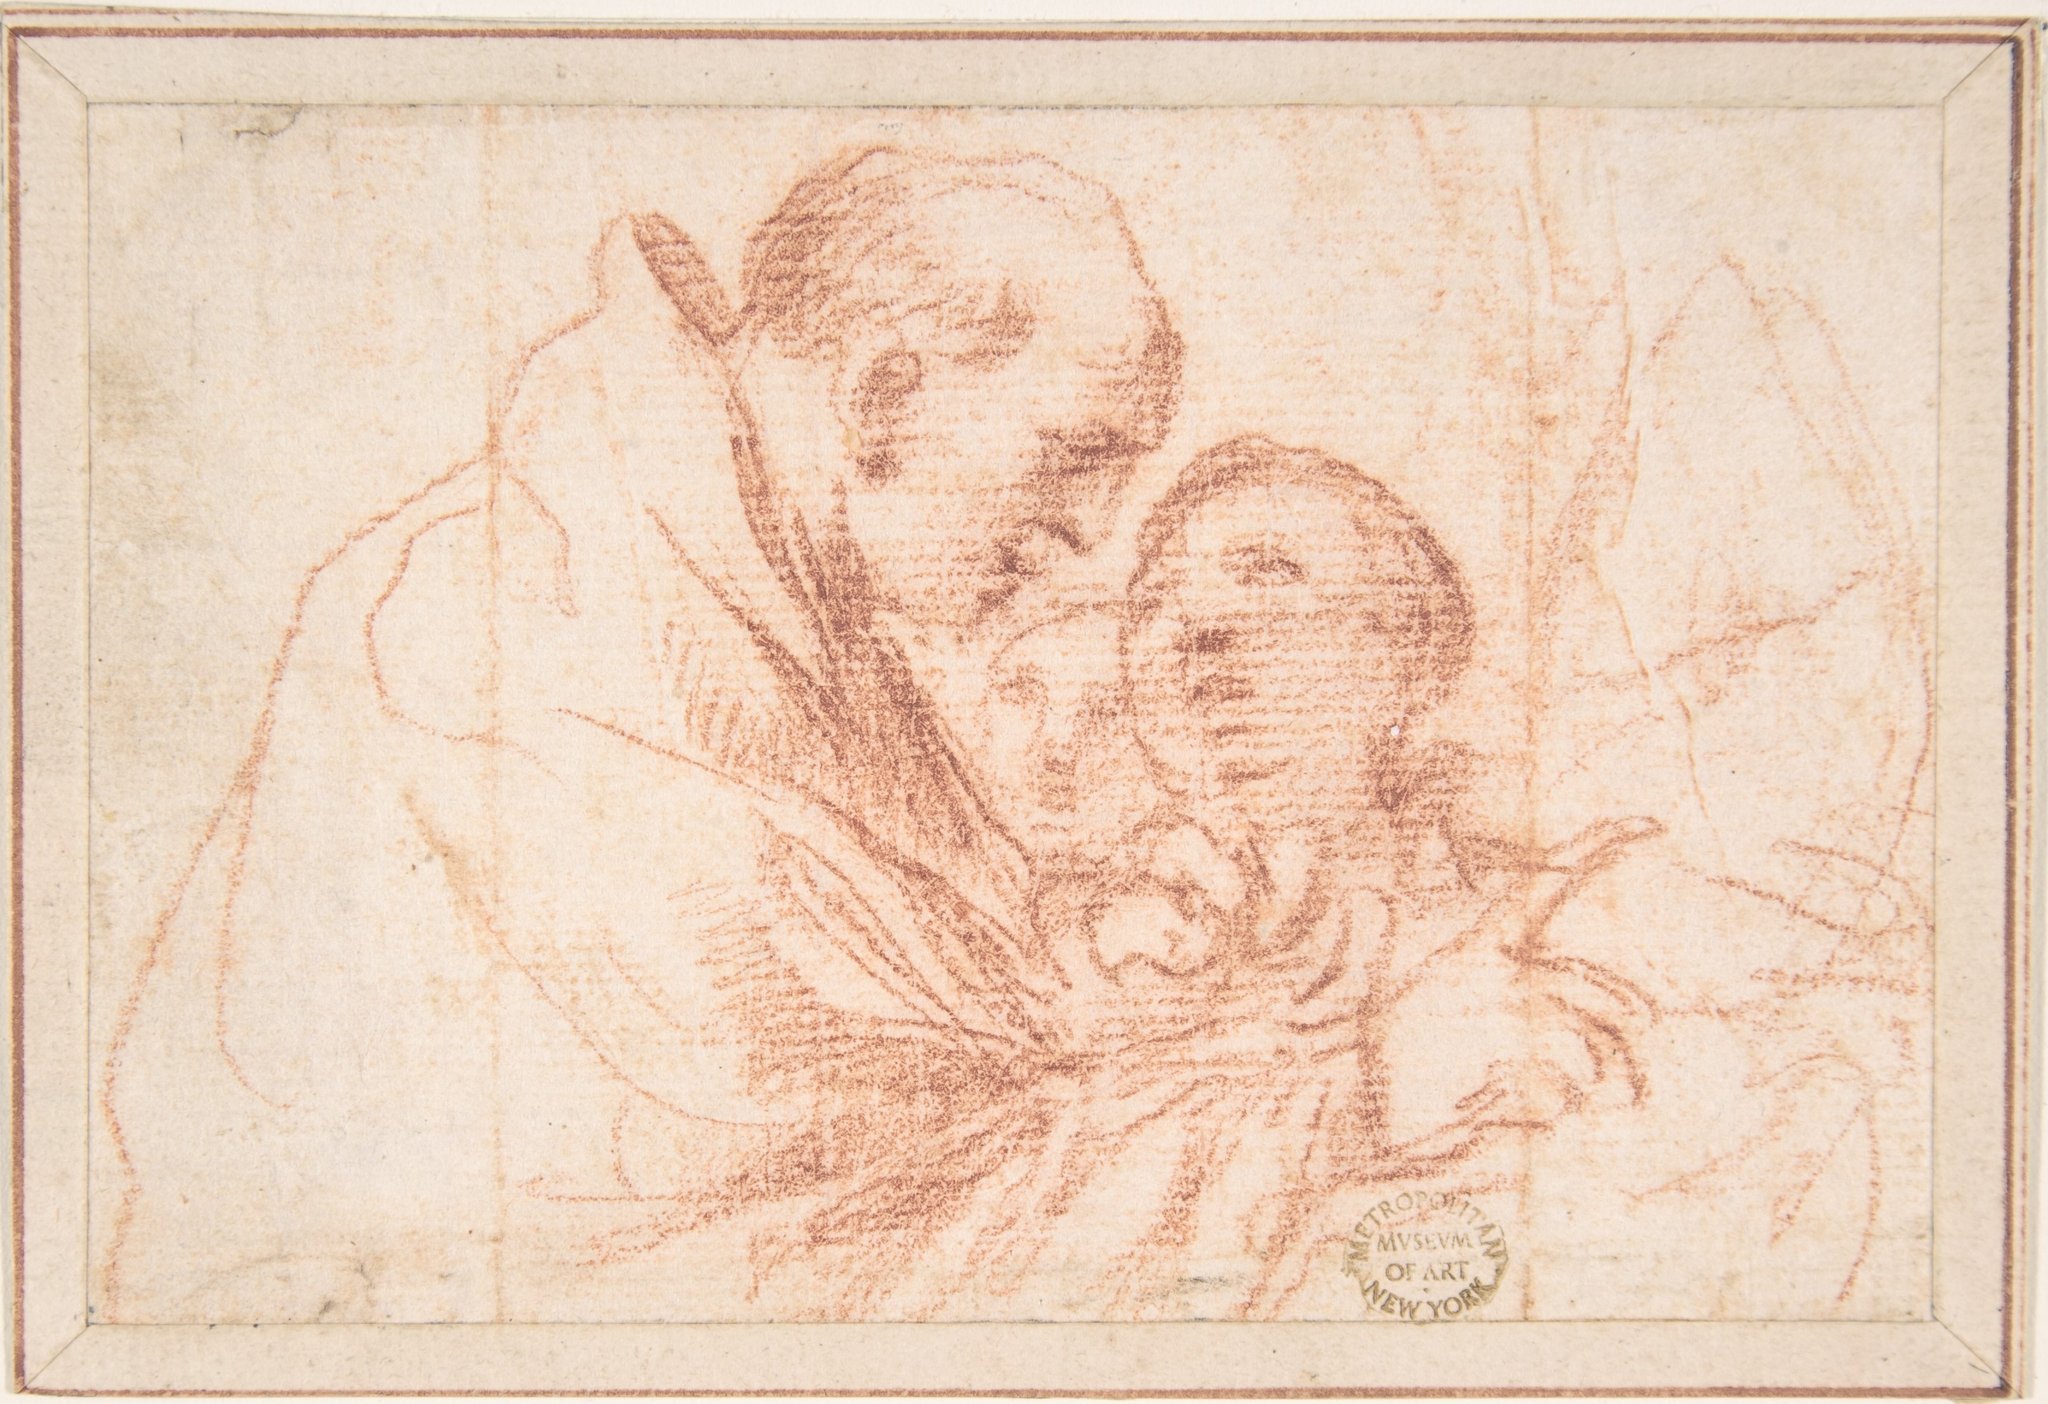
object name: drawing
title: Man and Boys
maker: anonymous, italian, roman-bolognese, 17th century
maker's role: artist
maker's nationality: italian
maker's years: 1600-1700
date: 1601-1700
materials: chalk, paper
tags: boys,men